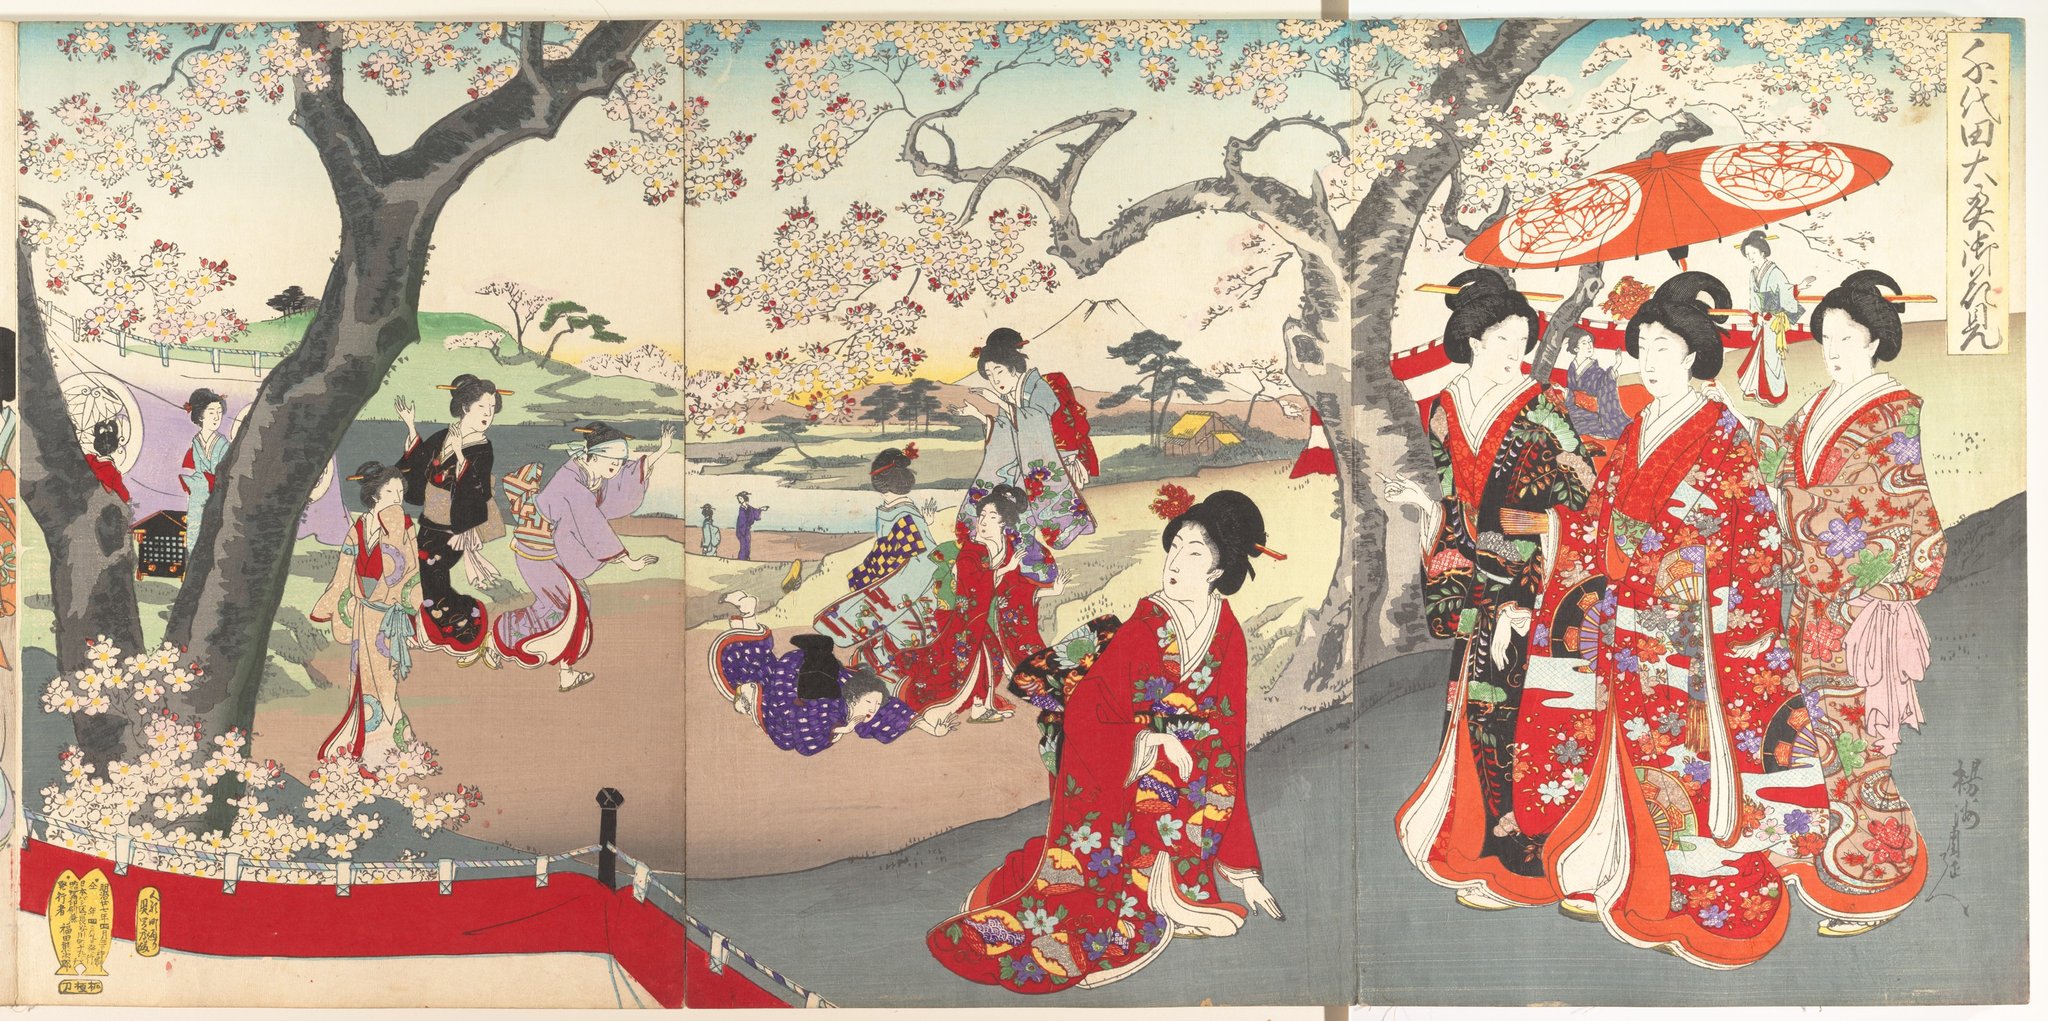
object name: print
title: Chiyoda Castle (Album of Women)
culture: japanese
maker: yōshū (hashimoto) chikanobu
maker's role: artist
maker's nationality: japanese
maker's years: 1838-1912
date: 1895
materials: ink, paper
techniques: woodblock print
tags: women,flowers,trees